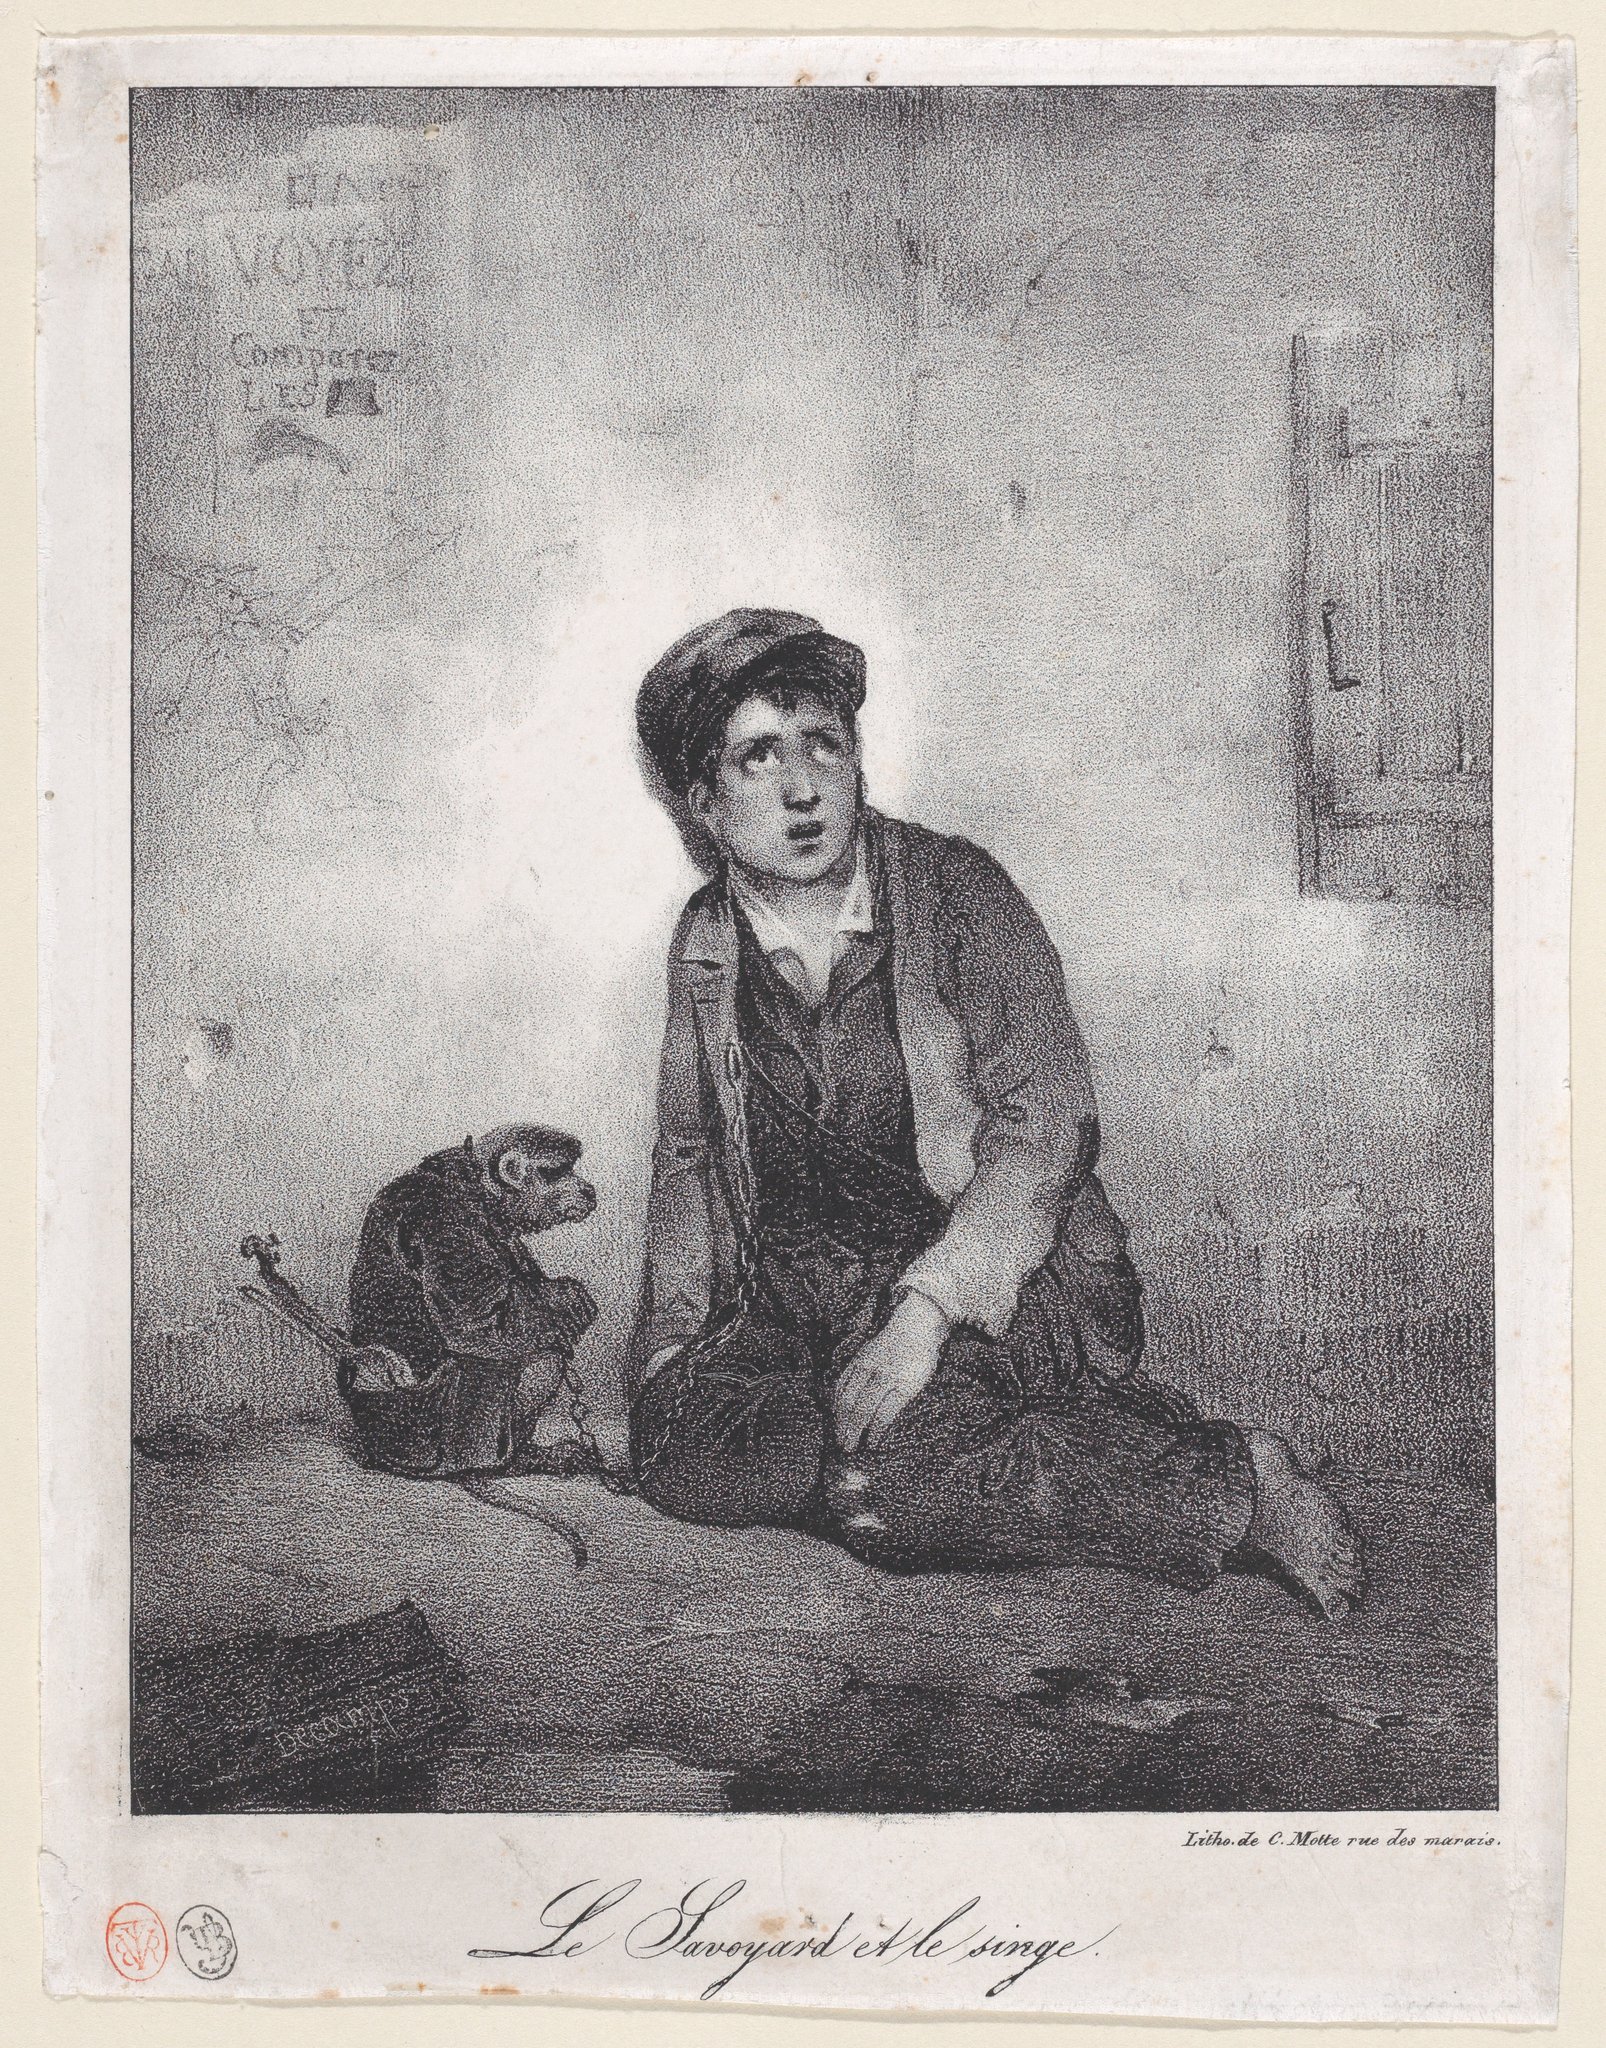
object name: print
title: The Boy from Savoy and His Monkey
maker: alexandre-gabriel decamps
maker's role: artist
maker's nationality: french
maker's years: 1803-1860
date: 1823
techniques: lithograph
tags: boys,monkeys